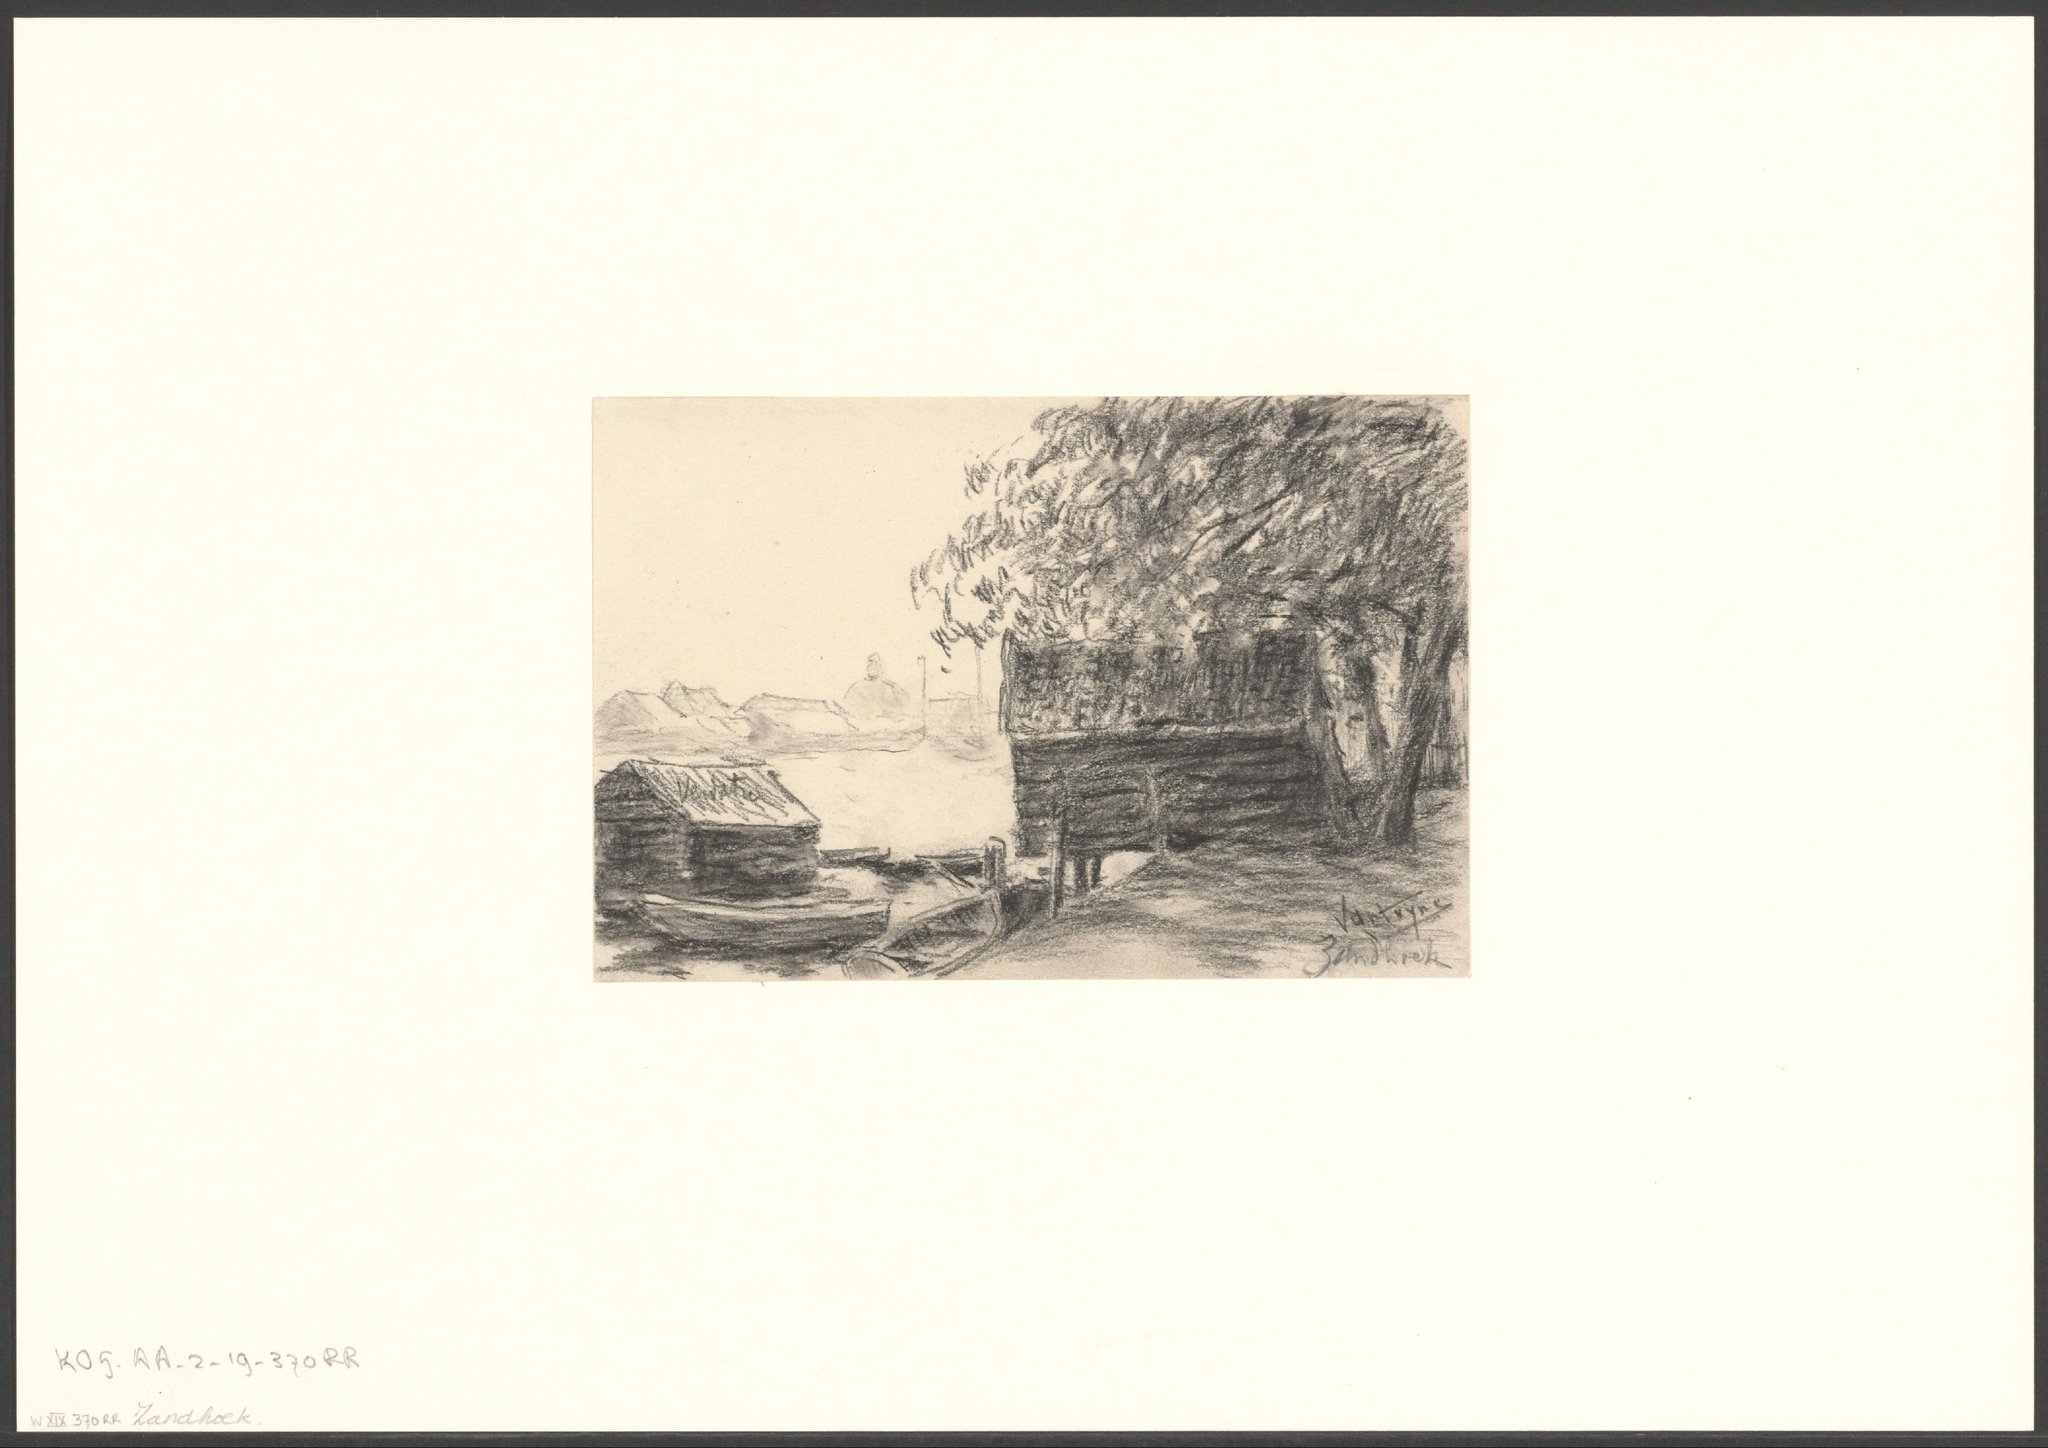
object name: drawing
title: Gezicht op de Zandhoek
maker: anthonie van teijn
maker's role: draughtsman, painter, print maker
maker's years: 1863-1943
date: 1873-1943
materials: chalk, paper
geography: amsterdam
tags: city-view in general; 'veduta', canal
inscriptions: inscription: ‘Zandhoek’, signature: ‘VanTeyne’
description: Tekening binnen de Atlas Van Eck ingedeeld op wijknummer 19.